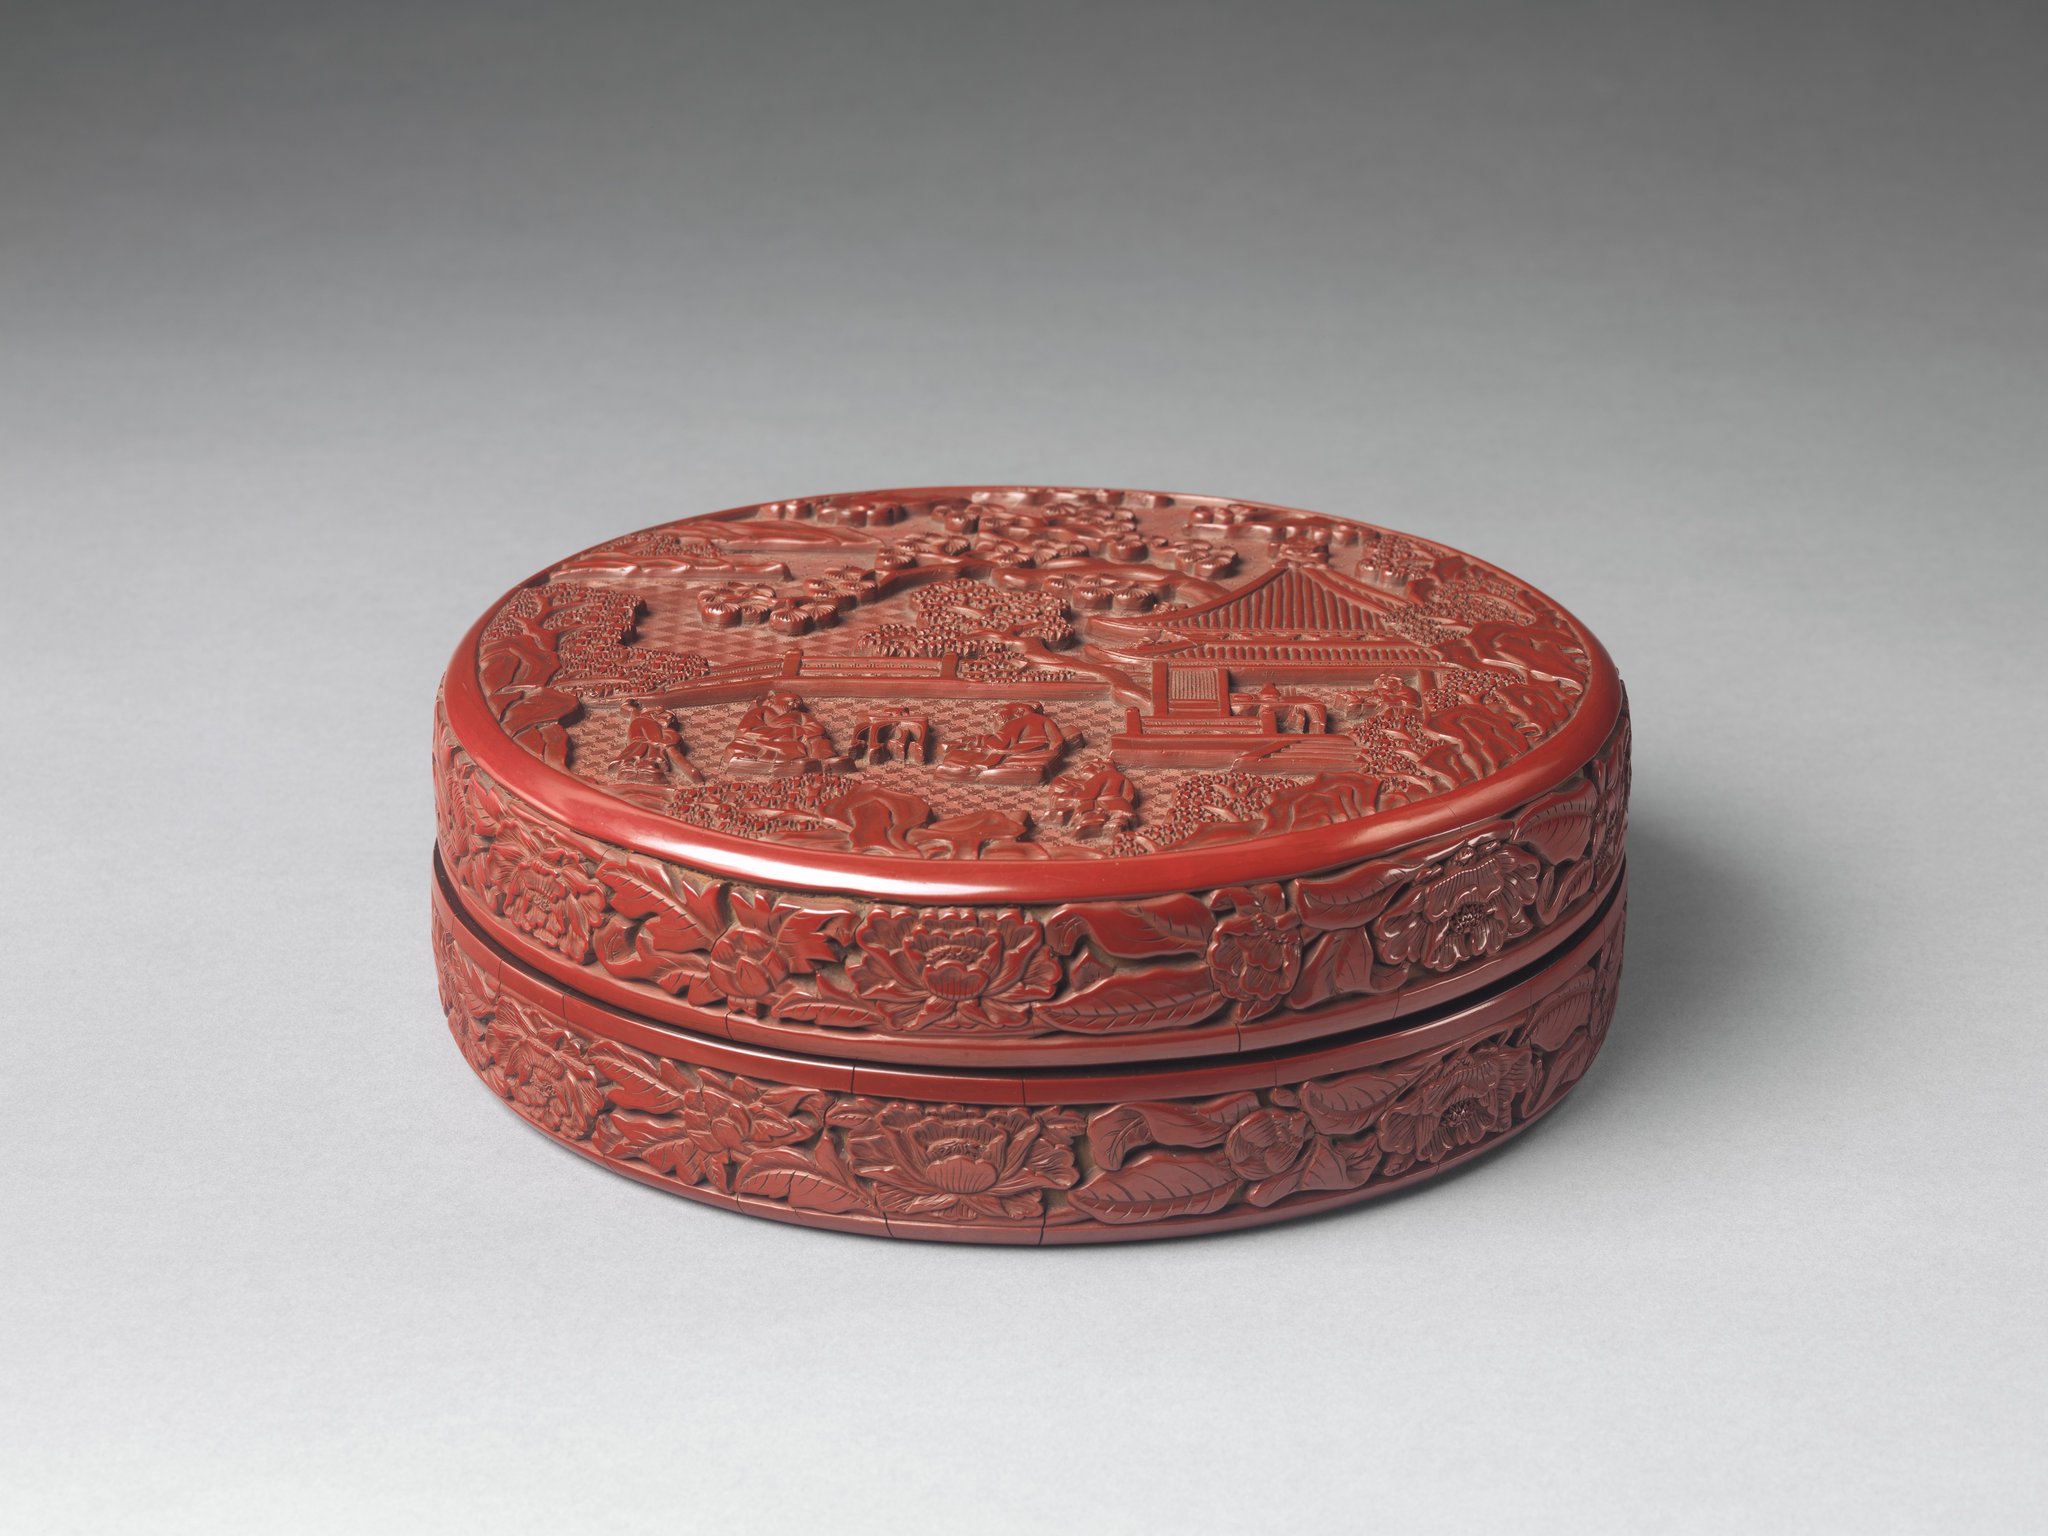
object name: box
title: Box with scene of a zither (qin) gathering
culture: chinese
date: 1403-1424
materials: lacquer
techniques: carving